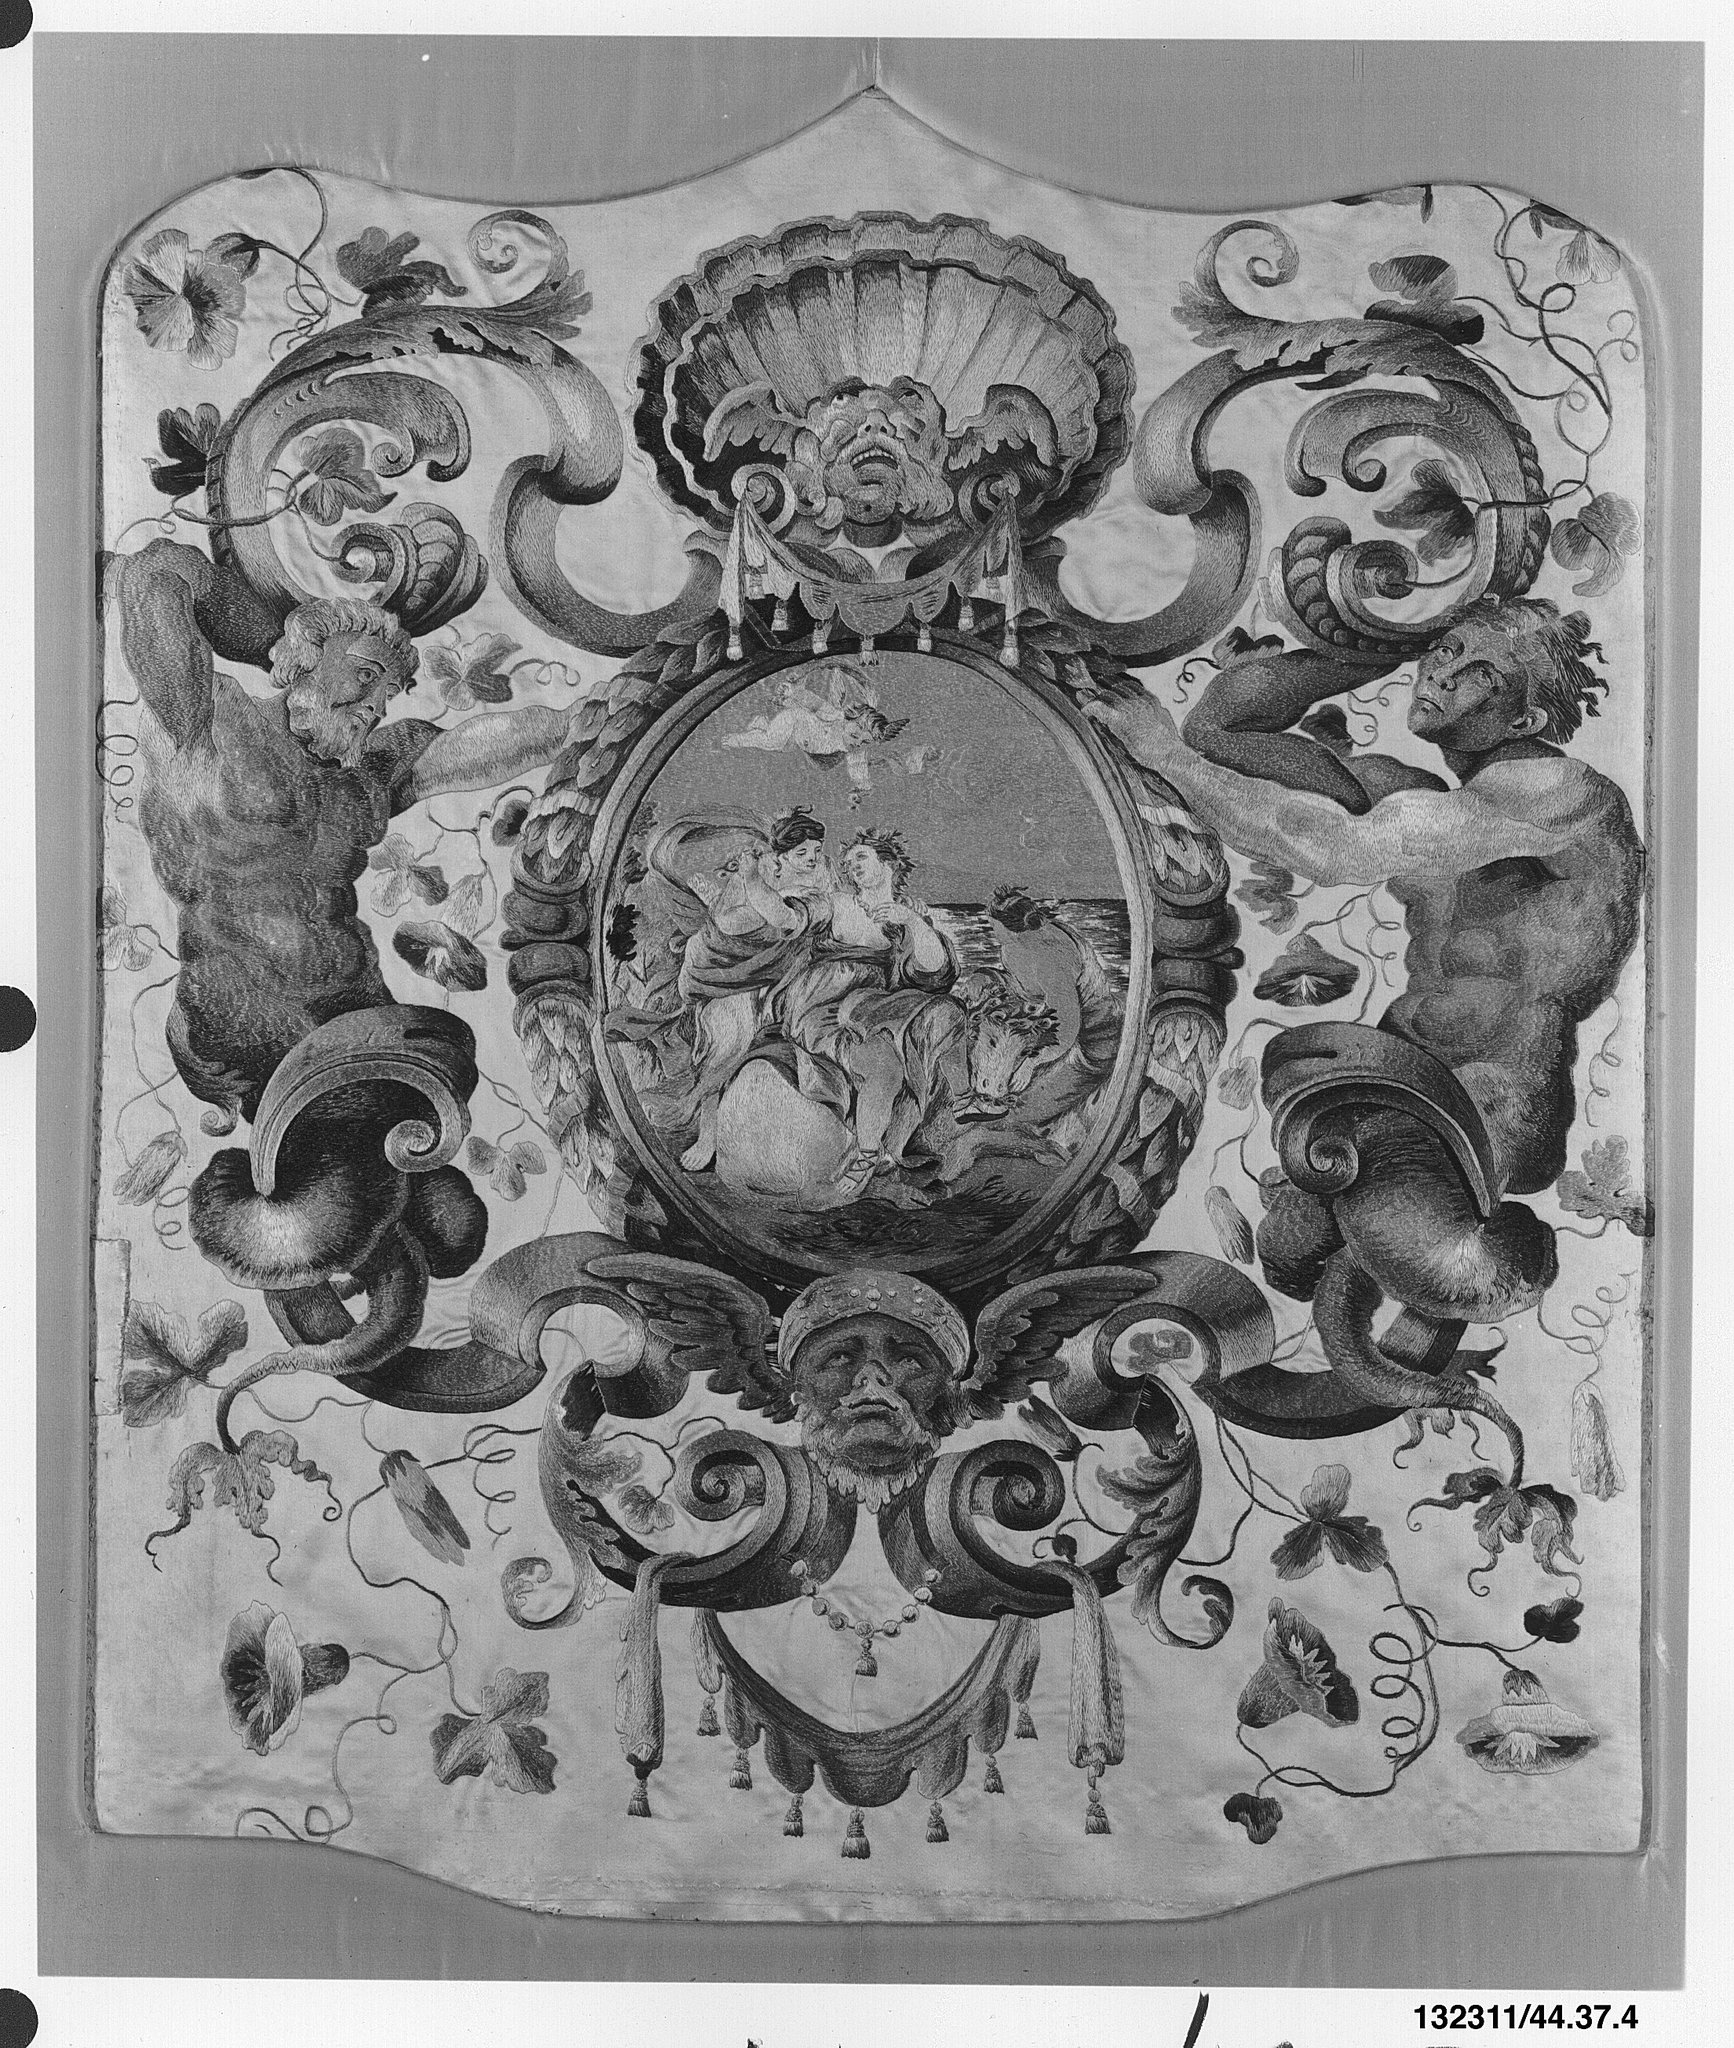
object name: upholstery panel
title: Chair panel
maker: daniel marot the elder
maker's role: maker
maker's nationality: french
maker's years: 1661-1752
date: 1701-1733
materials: silk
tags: women,bulls